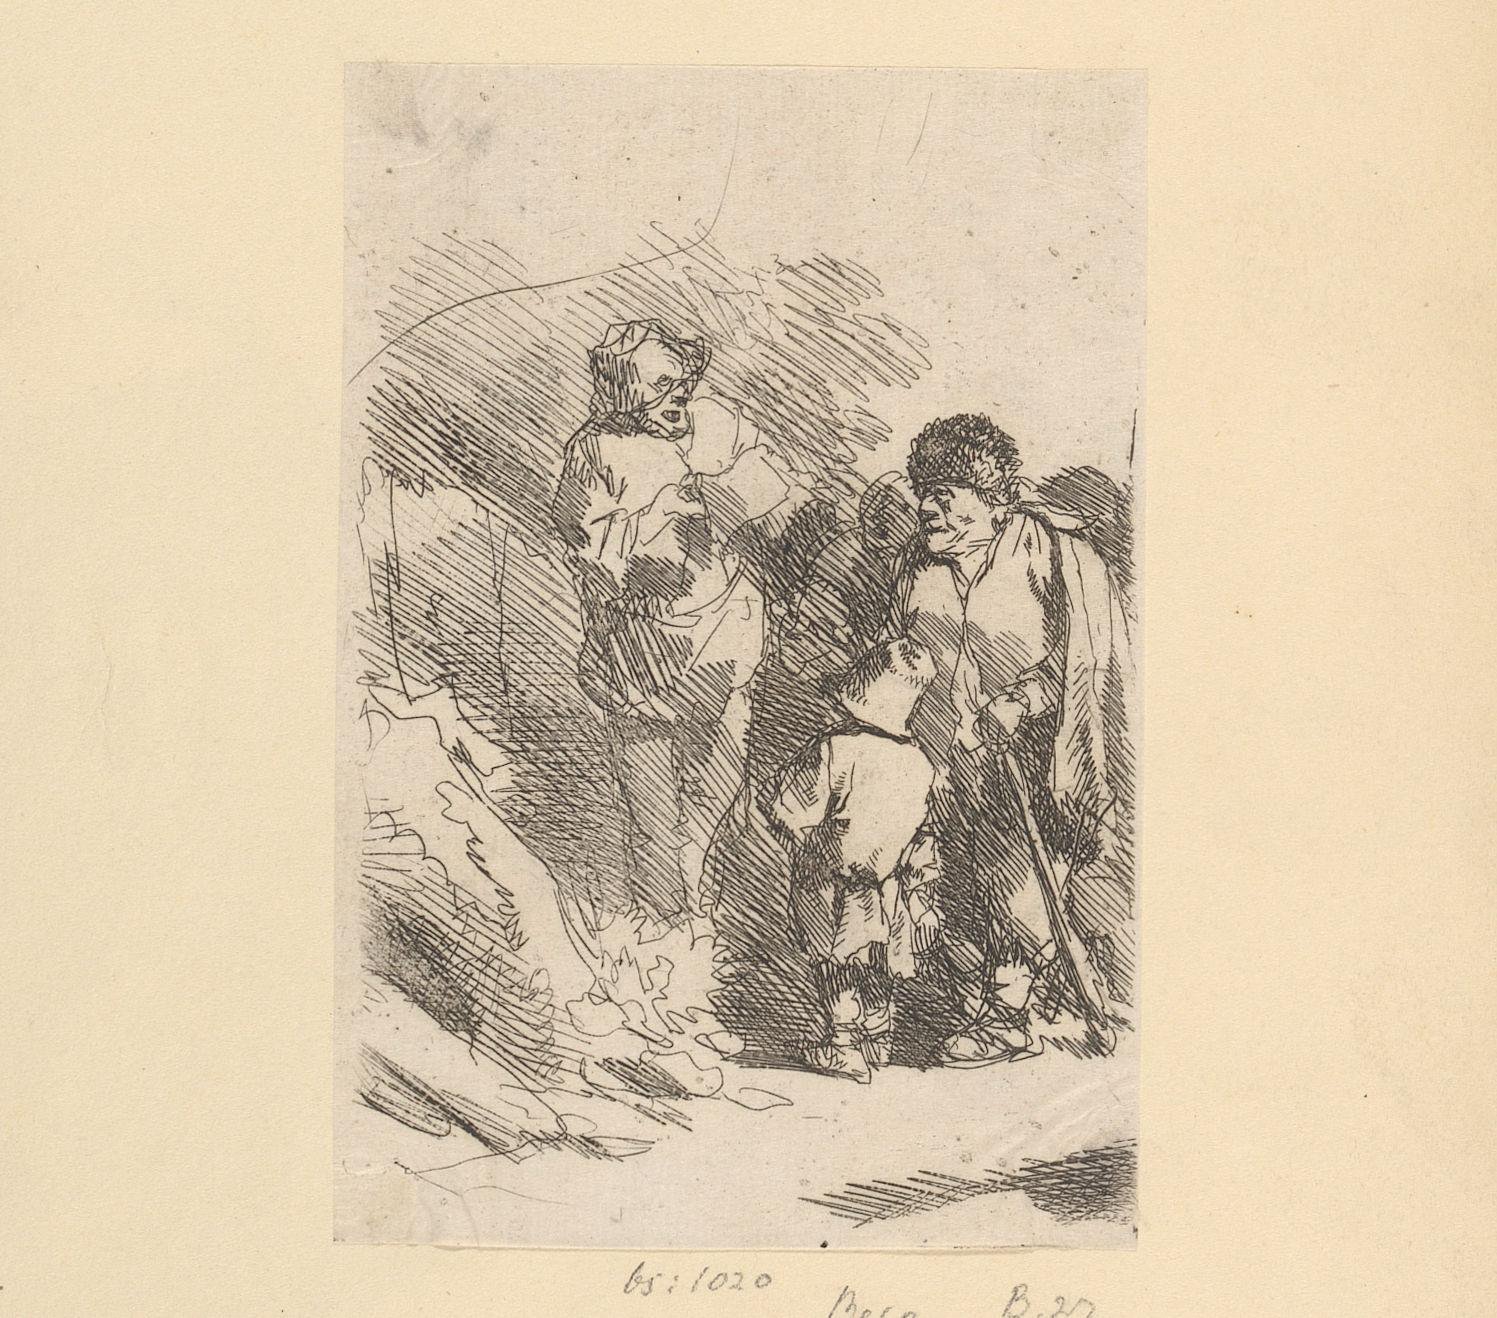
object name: print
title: Zingende man en luisterend publiek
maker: cornelis pietersz. bega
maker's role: draughtsman, painter, print maker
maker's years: 1631-1664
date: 1642-1664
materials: paper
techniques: etching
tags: vocal music, singing, male sex; man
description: Prent maakt mogelijk deel uit van een serie van 200 prenten. Deze serie is onder de titel 'A Collection of two hundred original etchings' voor het eerst uitgegeven door J.M. Greery in 1816.